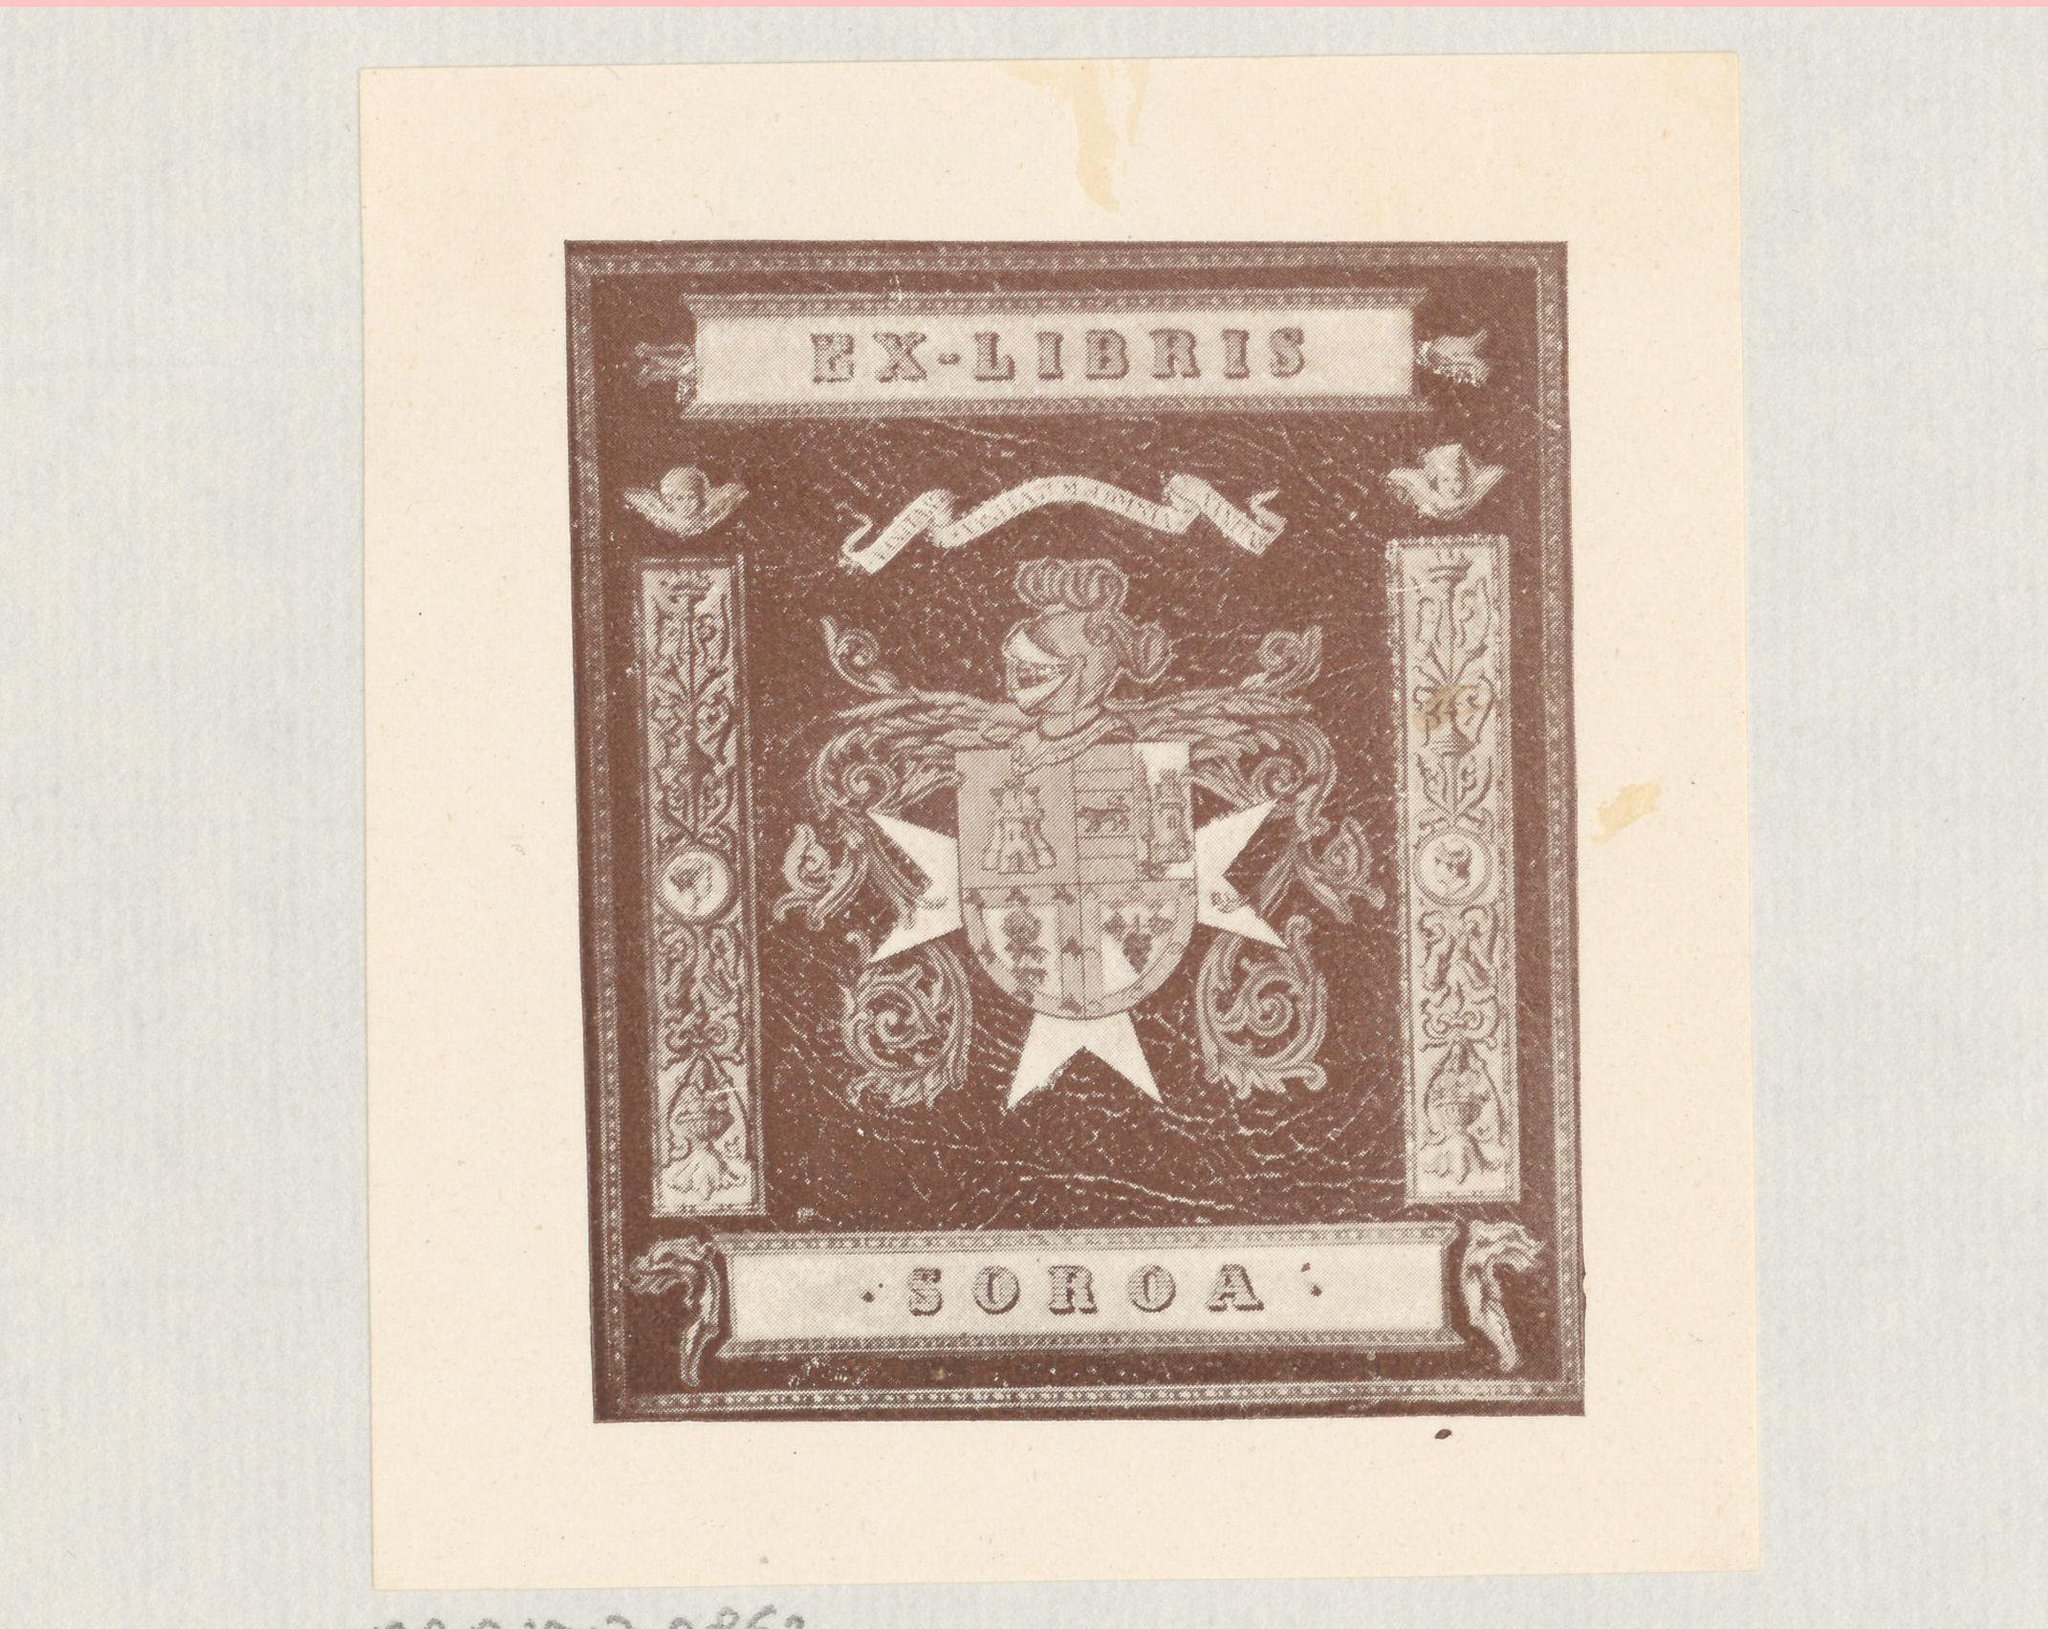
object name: photomechanical print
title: Ex libris van Soroa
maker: Anonymous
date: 1900-1999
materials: paper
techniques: autotype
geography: spain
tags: cherubs, i.e. children's heads with wings, ribbon, scroll, banderole ~ ornament, armorial bearing, heraldry